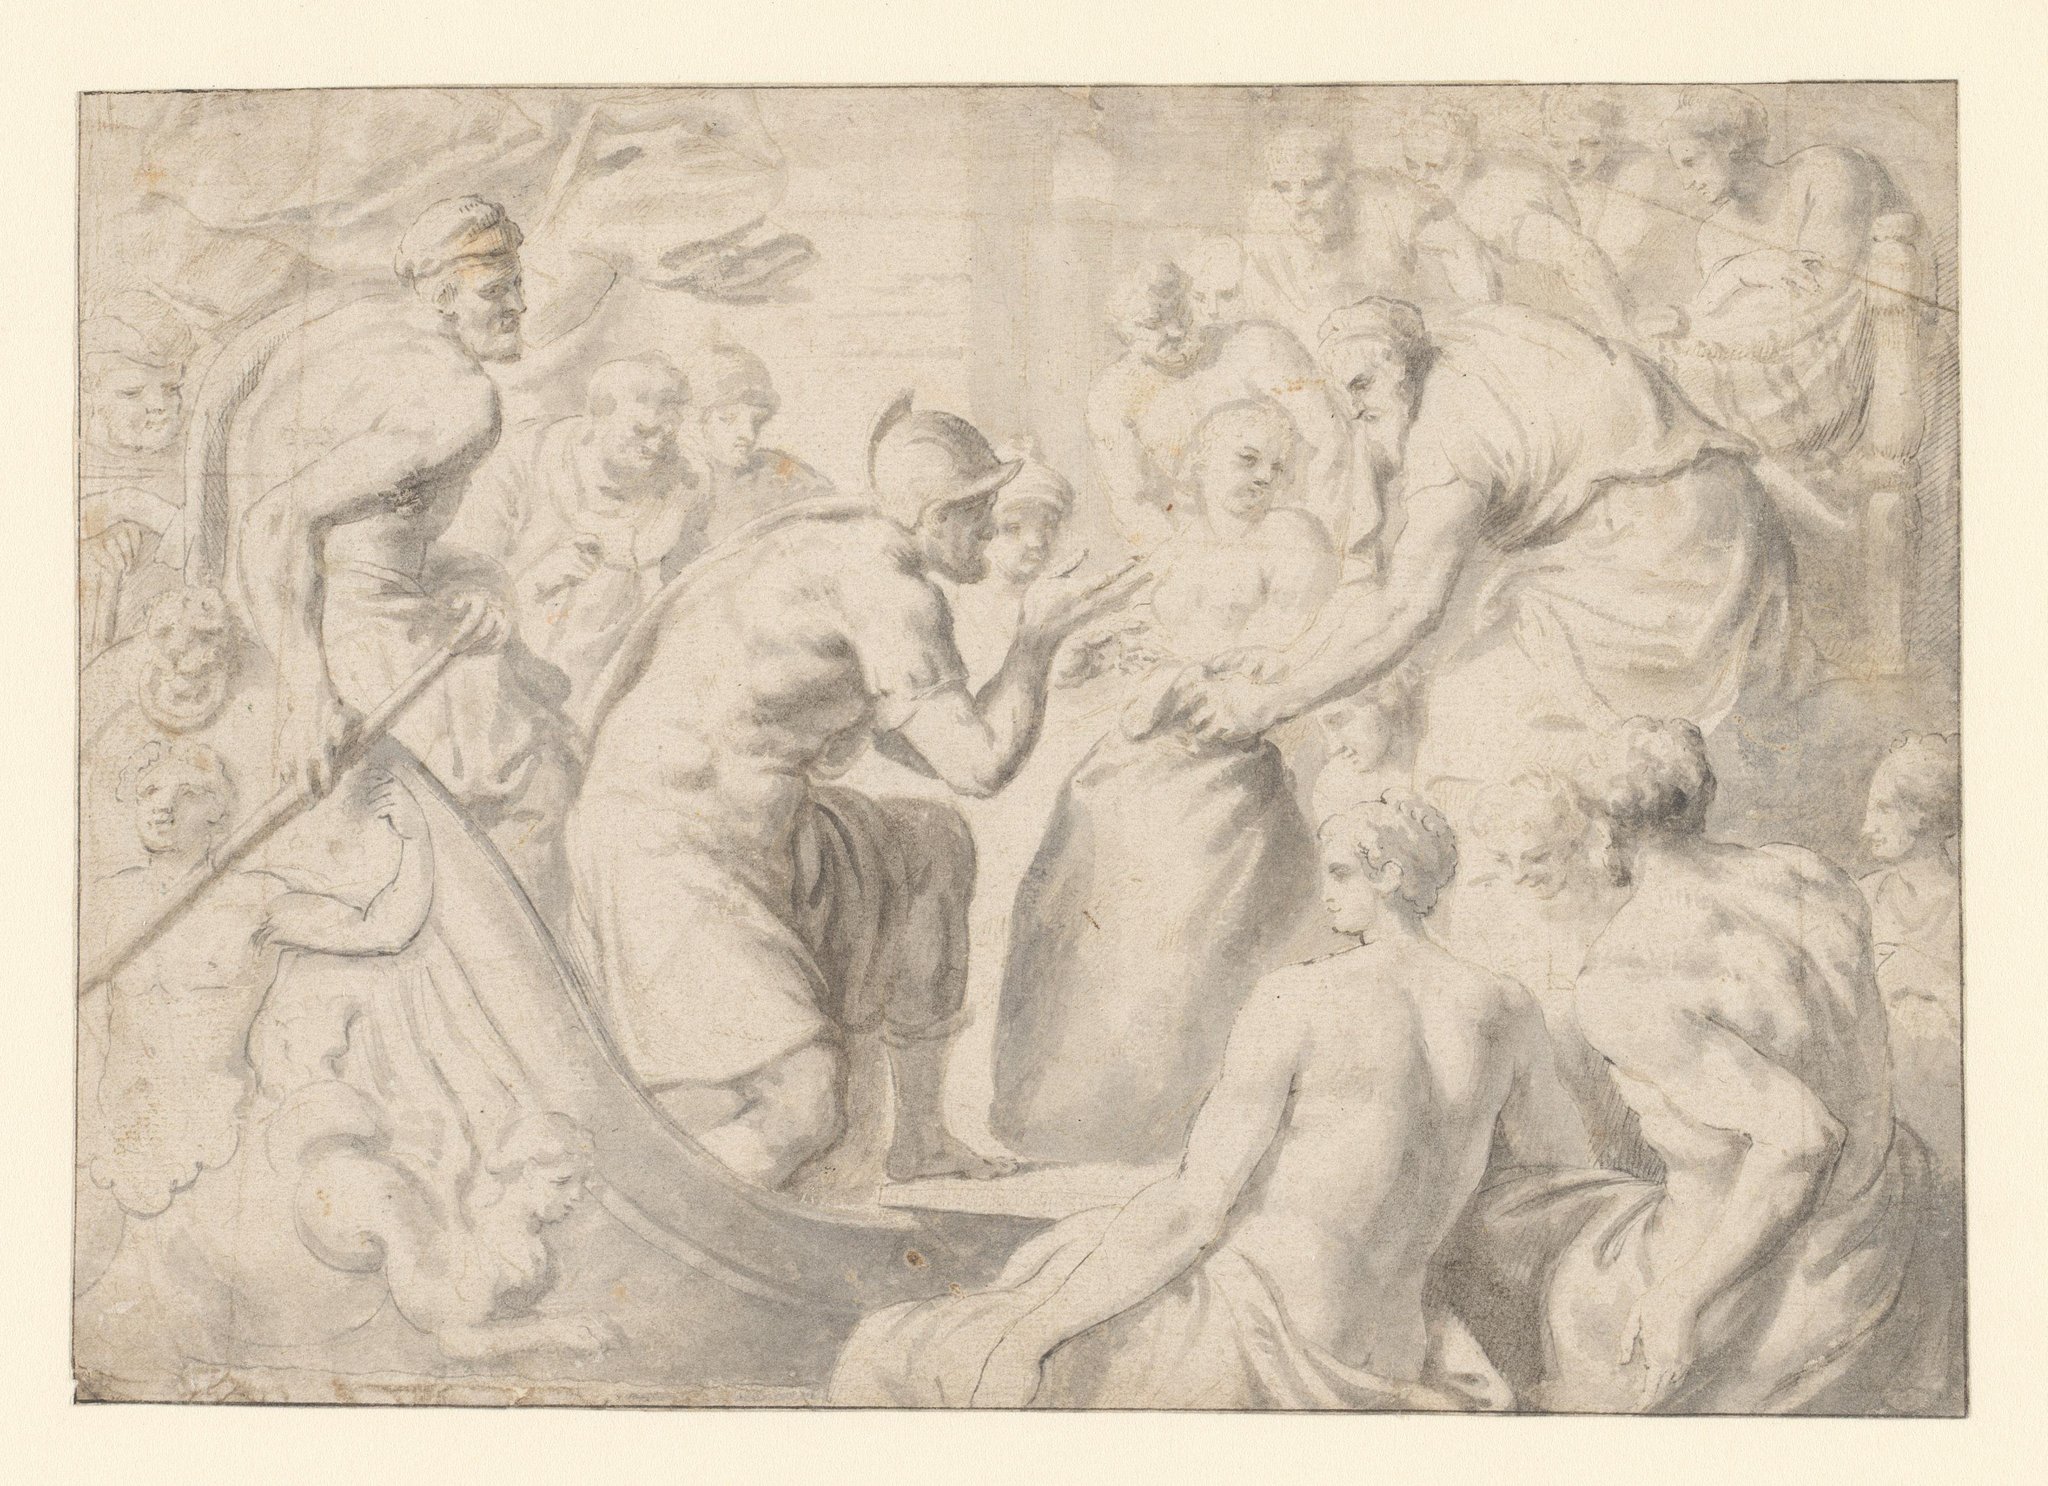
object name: design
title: De metgezellen van Odysseus maken de zak open waarin Aeolus de winden besloten had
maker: theodoor van thulden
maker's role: draughtsman, painter, print maker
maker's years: 1606-1669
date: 1631-1633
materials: ink, paper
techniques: brush, pen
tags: while ulysses is asleep, his companions open the bag; contrary winds rush out